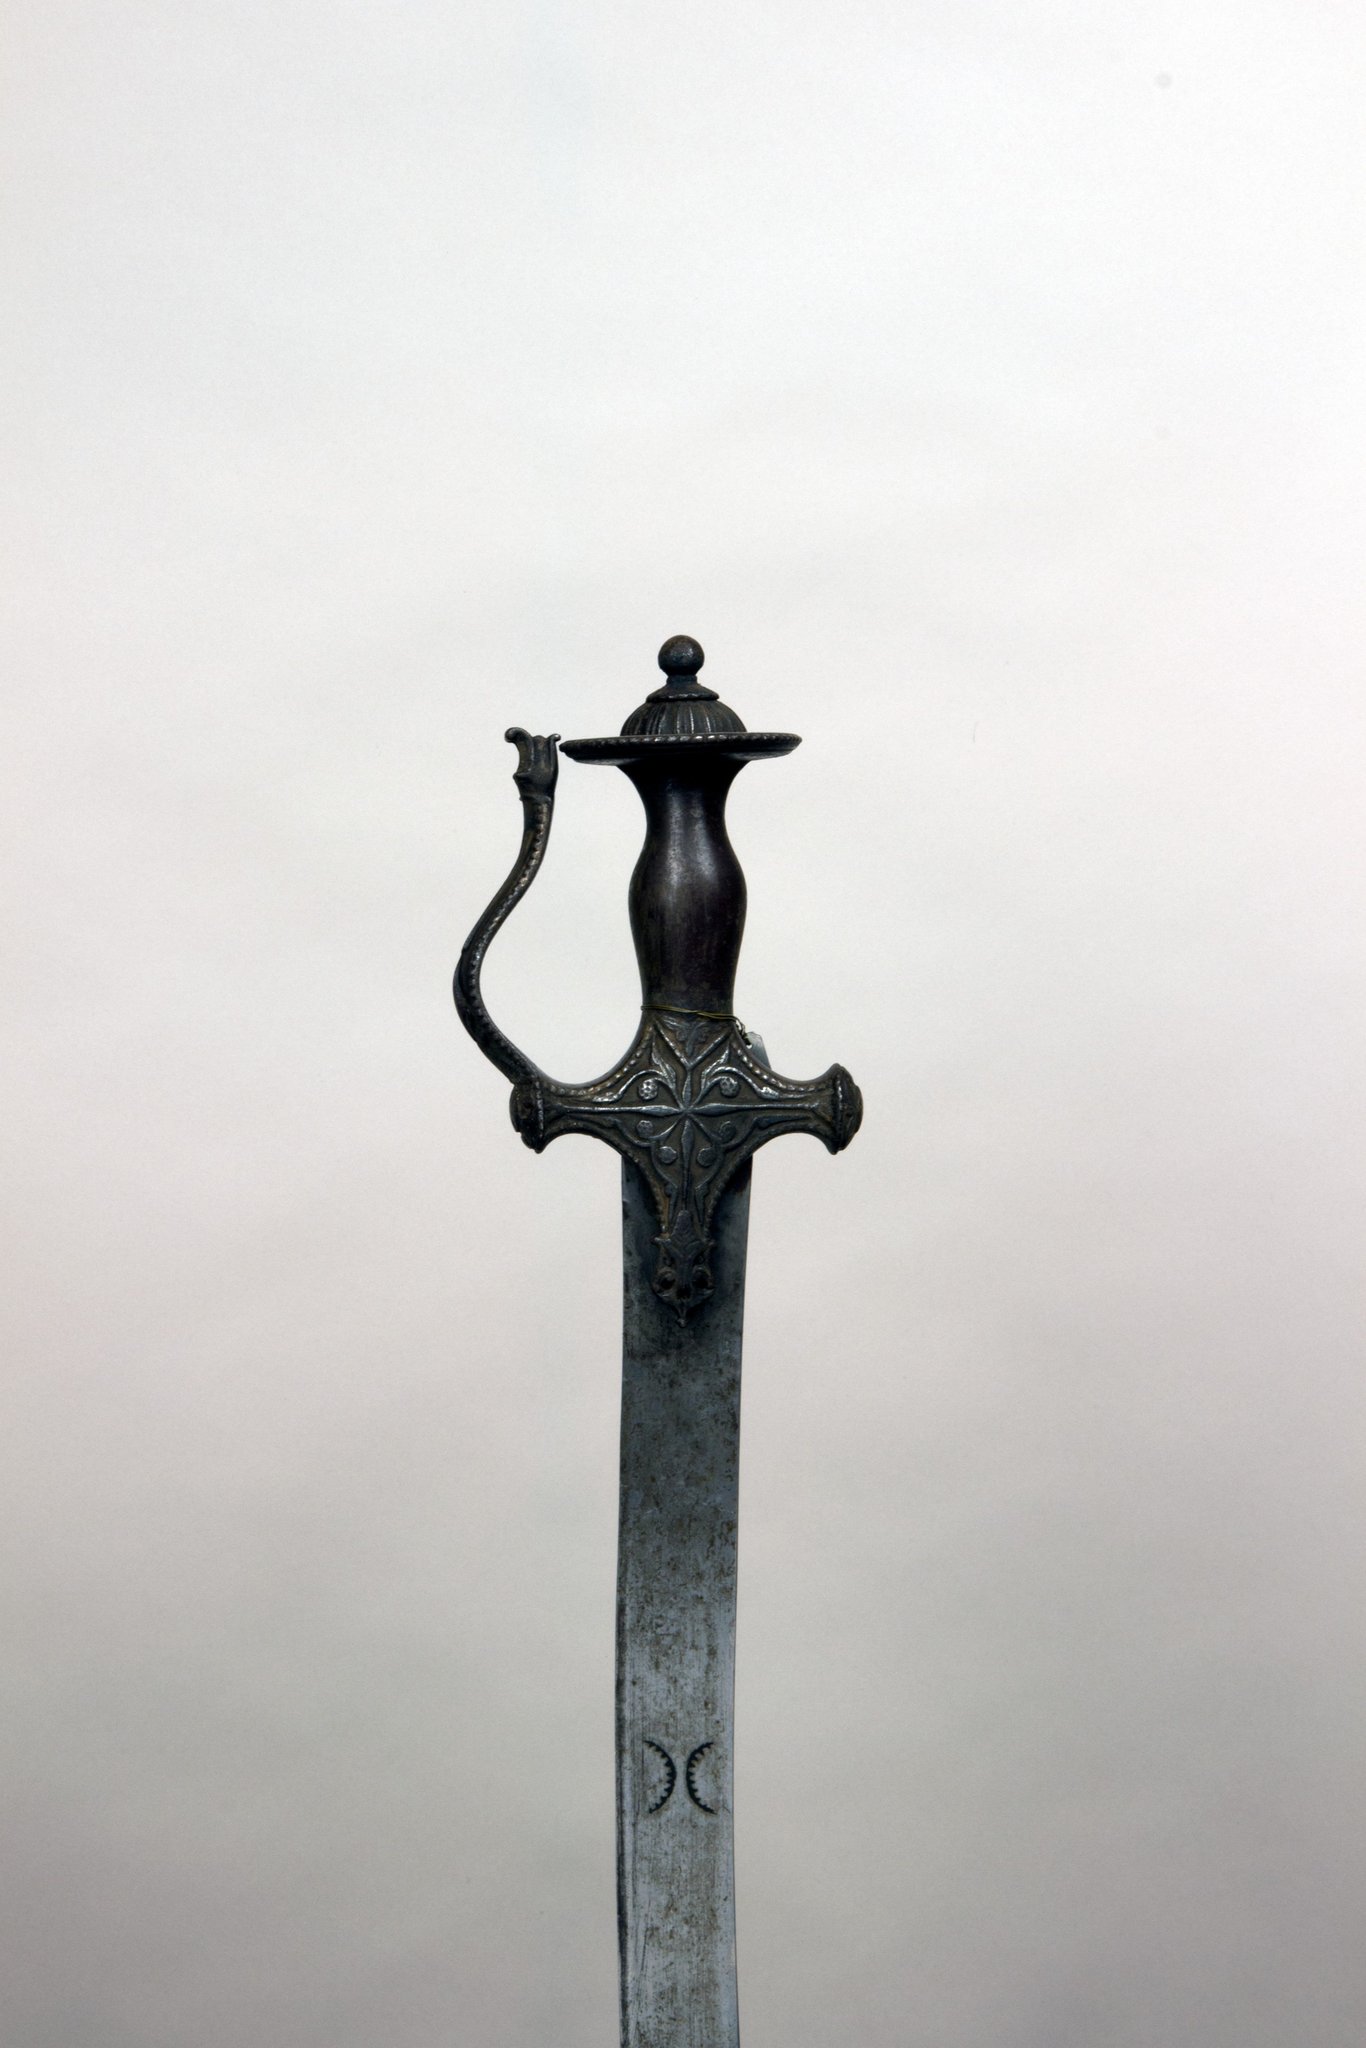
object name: sword talwar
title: Sword (Talwar)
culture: indian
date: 1701-1900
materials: silver, steel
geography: india